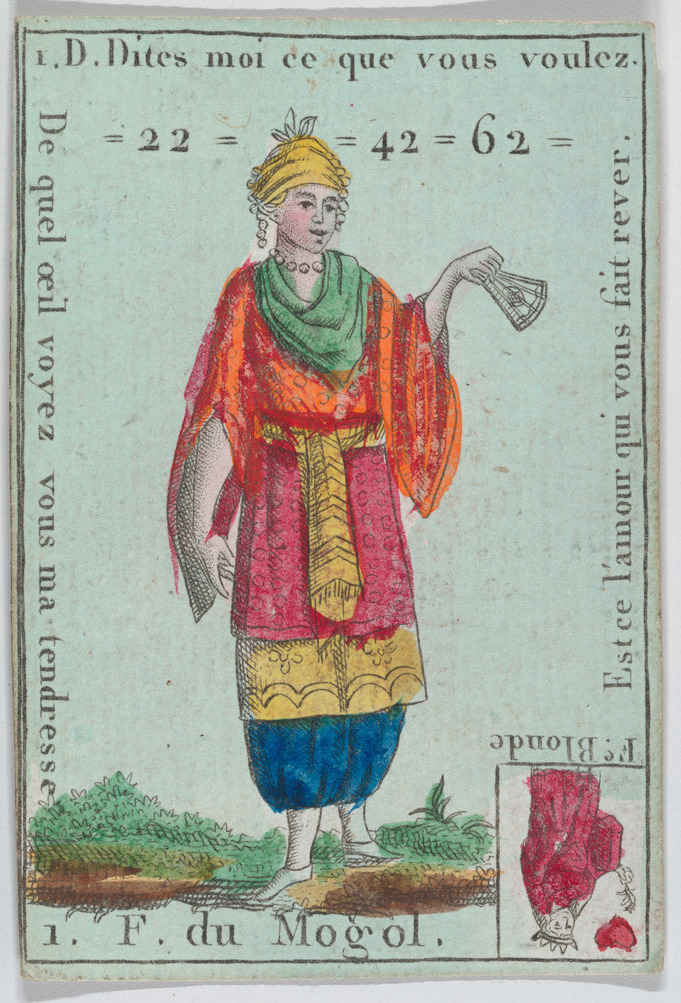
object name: print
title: F. du Mogol from playing cards "Jeu d'Or"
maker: anonymous, french, 18th century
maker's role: artist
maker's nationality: french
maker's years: 1700-1800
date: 1700-1799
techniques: etching, hand coloring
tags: portraits,women,playing cards